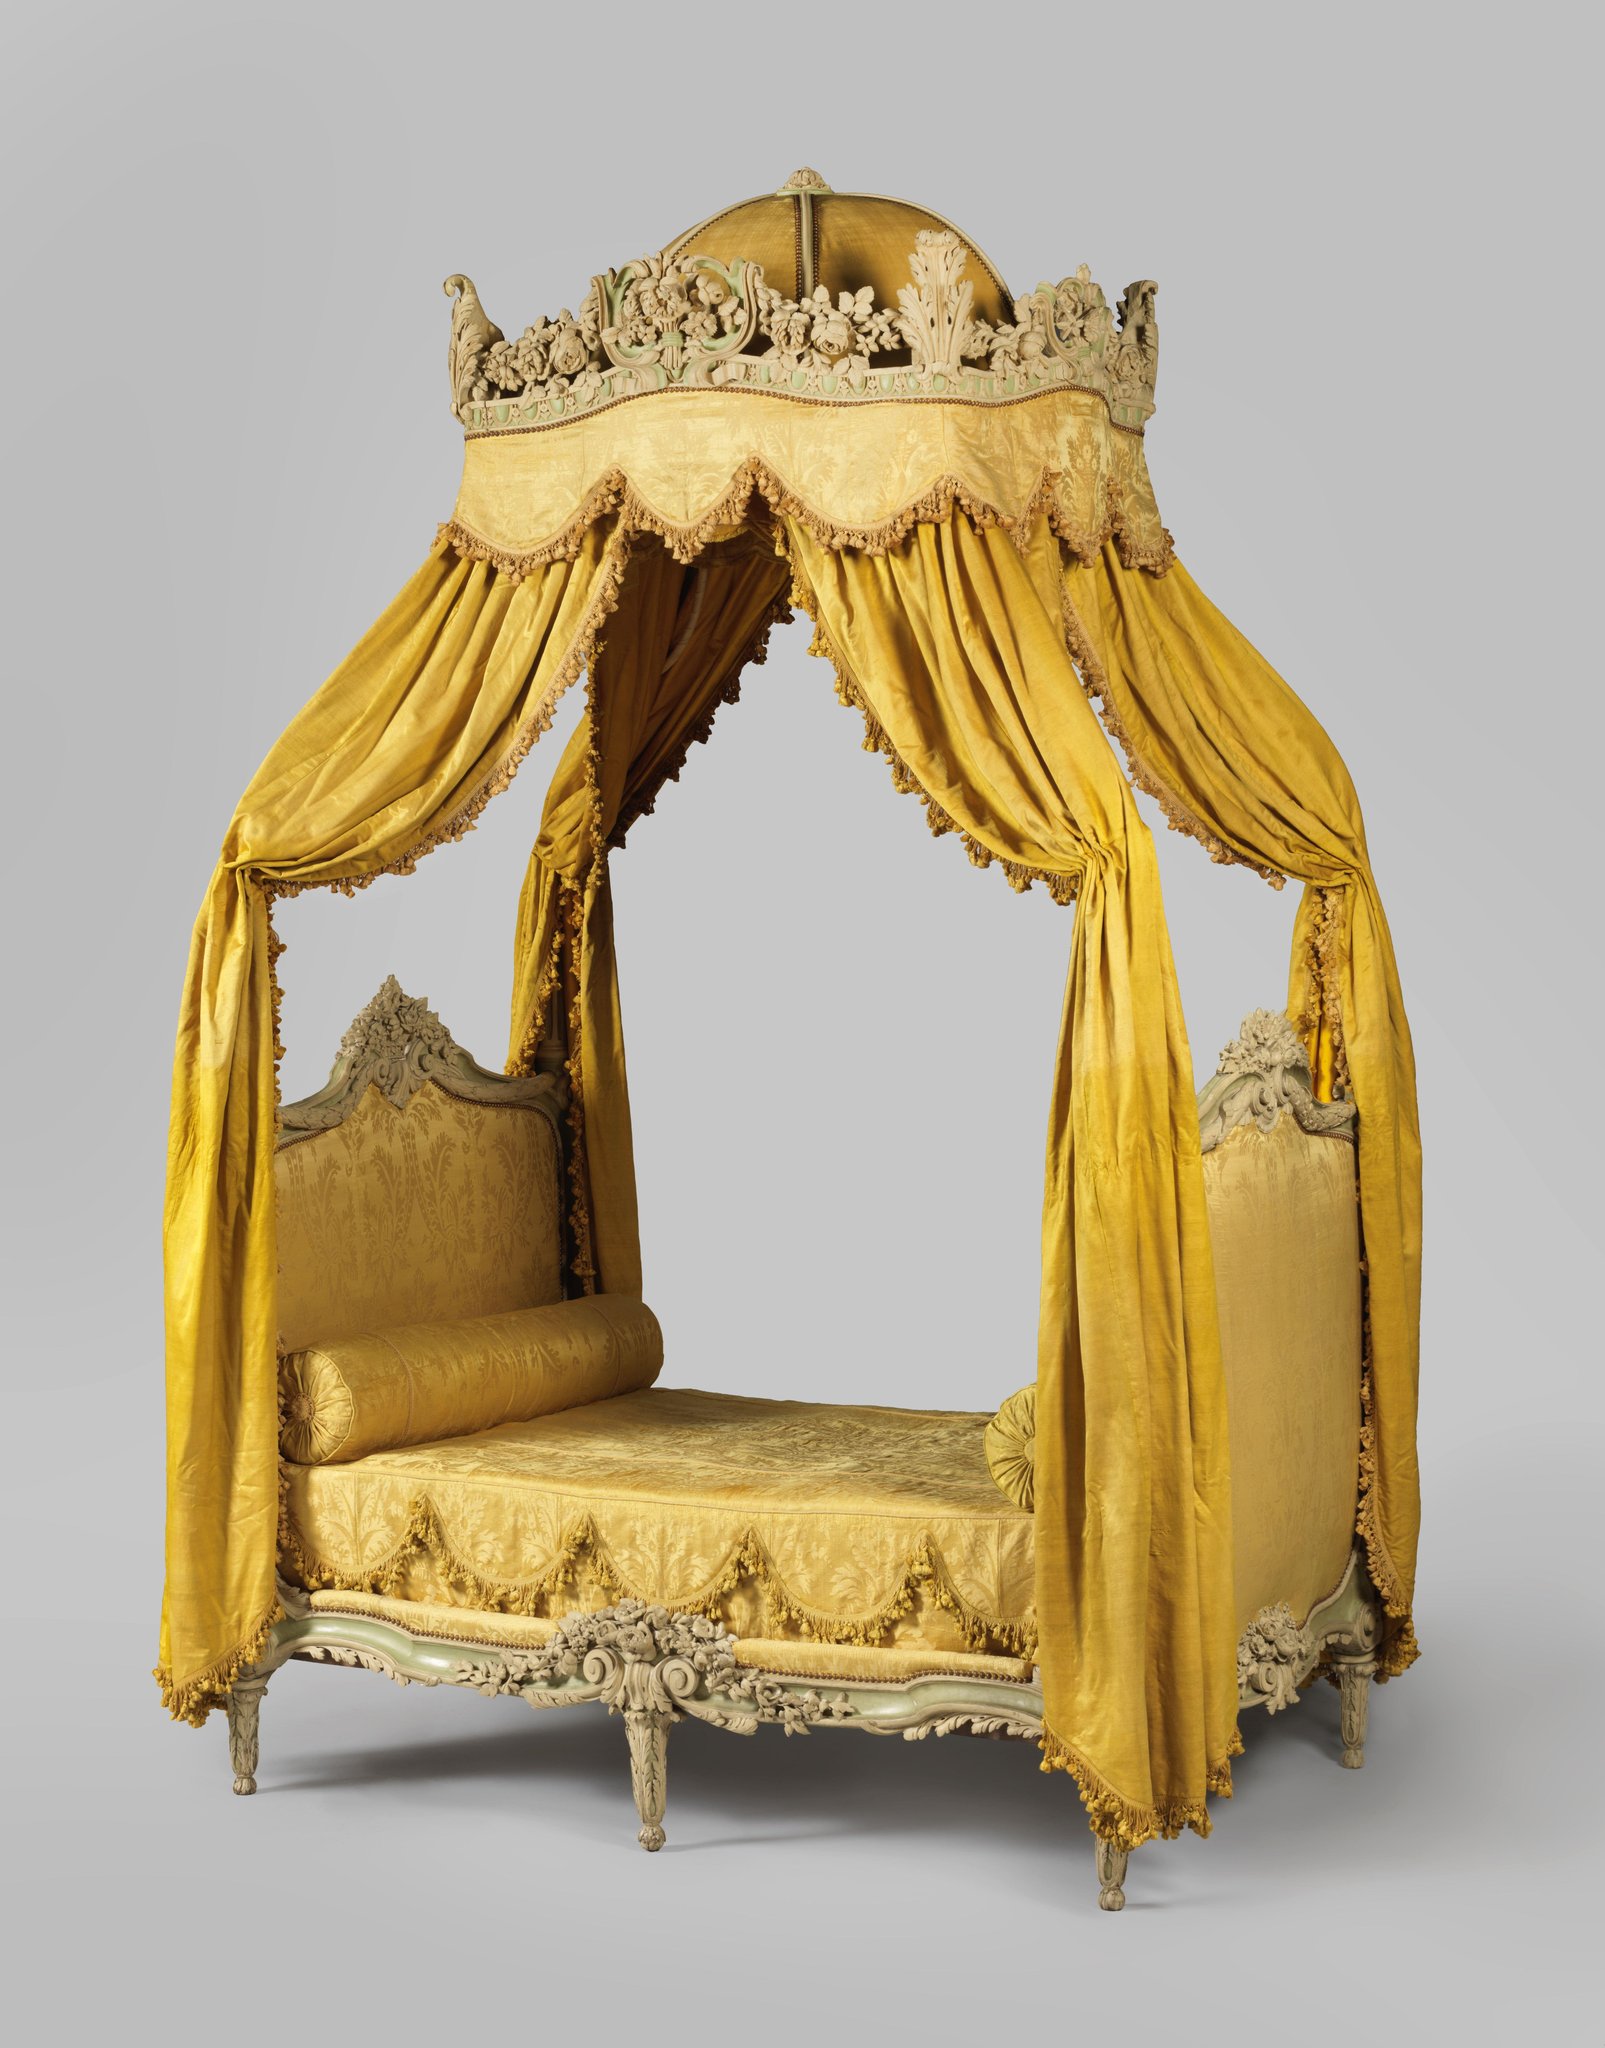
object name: furniture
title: Ijzeren steun voor de hemel van het Lit à la Polonaise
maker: Anonymous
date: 1775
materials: wood, copper, iron, paint, textile, silk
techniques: cutting, damask, painted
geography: france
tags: bed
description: Vier ijzeren s-vormige steunen voor de hemel.